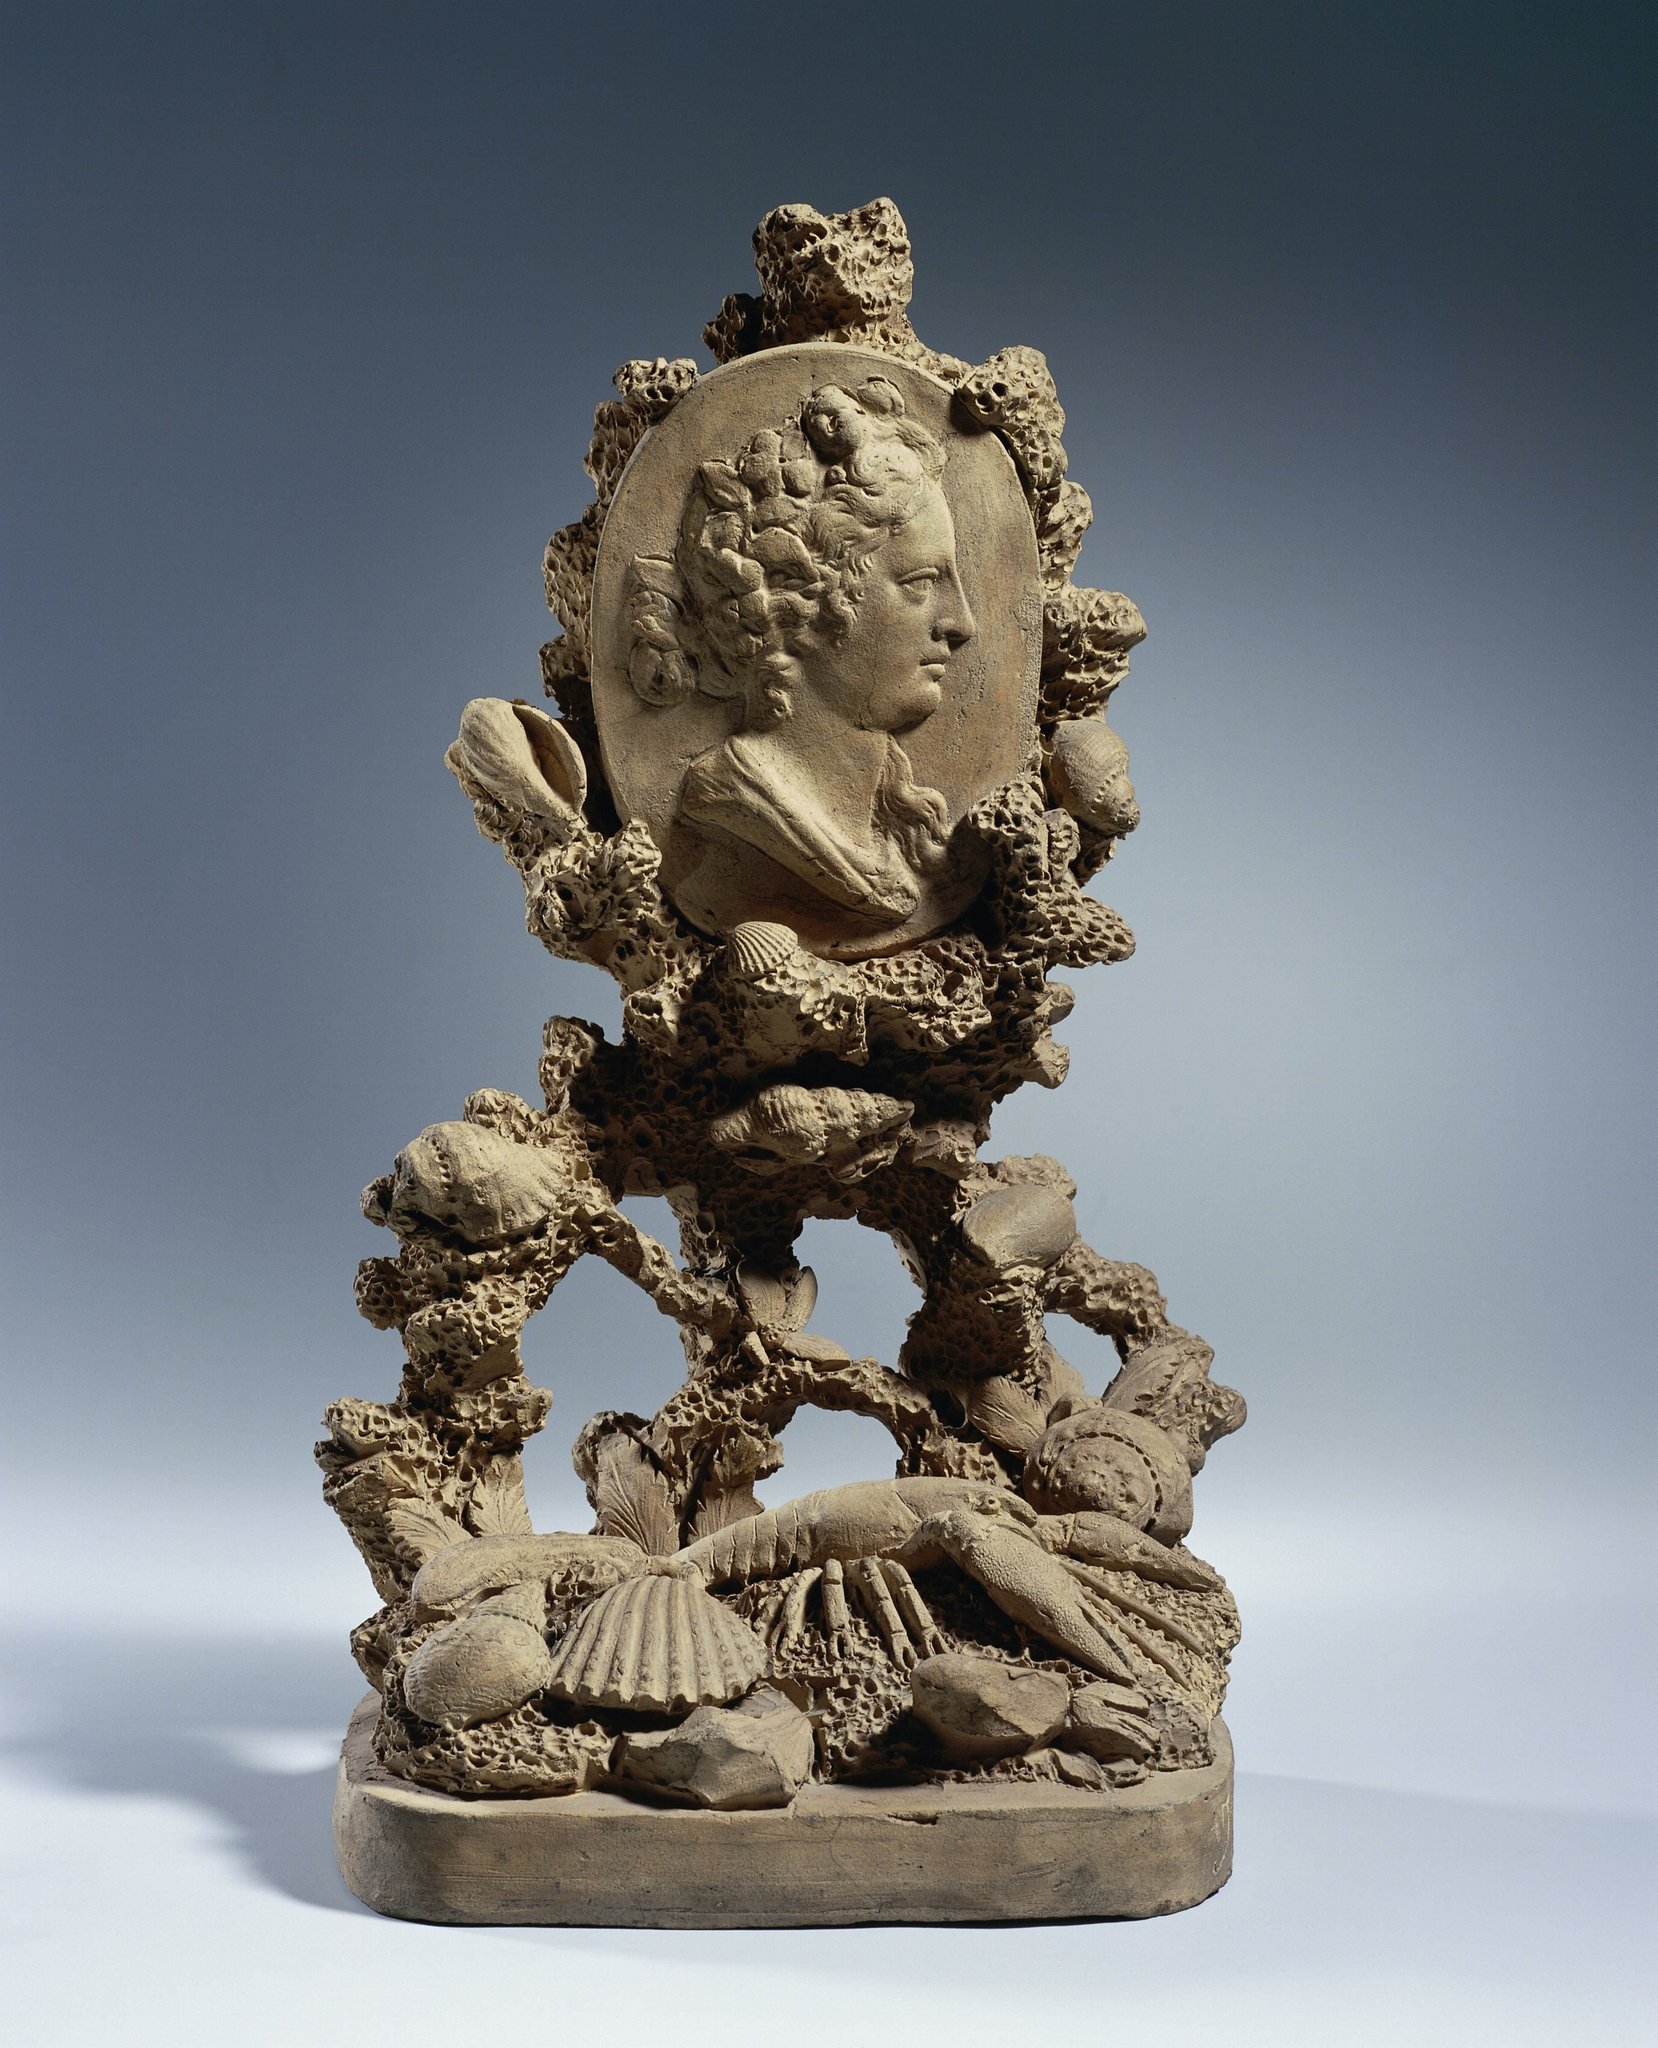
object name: sculpture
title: Medaillonportret van een vrouw, op imitatie-rotskoralen standaard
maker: jean-baptiste janelle (de jonge)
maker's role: sculptor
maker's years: -1764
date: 1741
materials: terracotta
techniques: modeling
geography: paris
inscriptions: signature and date: ‘Jannelle. le jne 1742’